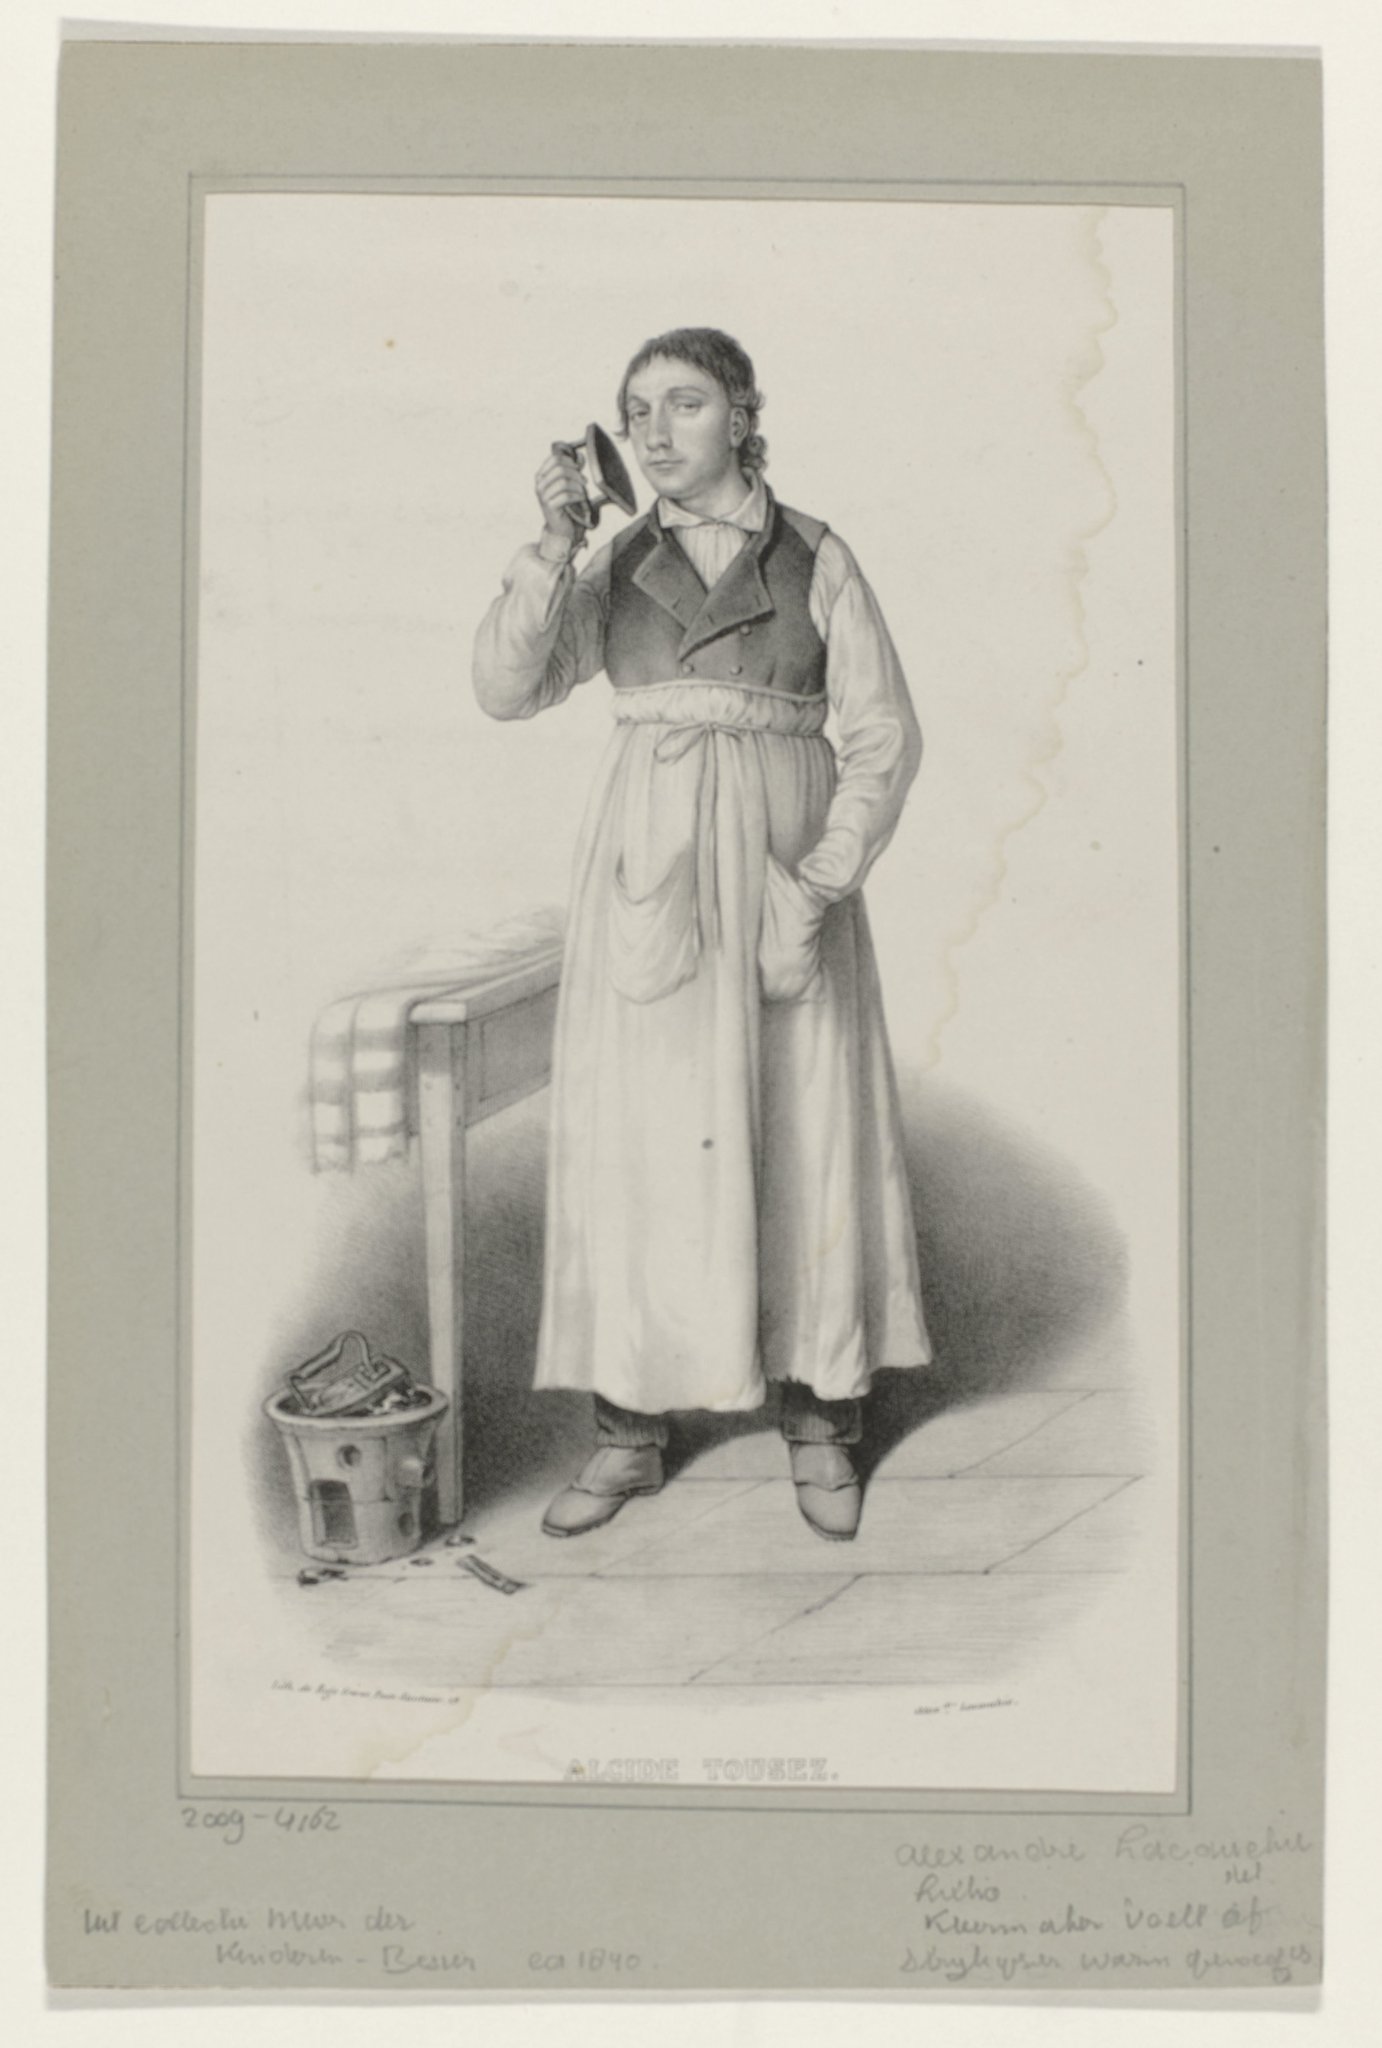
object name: print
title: De acteur Alcide Tousez als kleermaker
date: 1840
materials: paper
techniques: lithograph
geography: paris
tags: clothing for the upper part of the body (vest) (+ men's clothes), ironing, clothing for the upper part of the body (with name) (+ men's clothes), apron (+ men's clothes), actor (on the stage)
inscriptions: caption: ‘ALCIDE TOUSEZ.’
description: Portret van de acteur AlcideTousez in de rol van kleermaker die voelt of het strijkijzer warm genoeg is. Hemd waarover een double-breasted vest. Op de lange broek een lang schort met twee zakken.